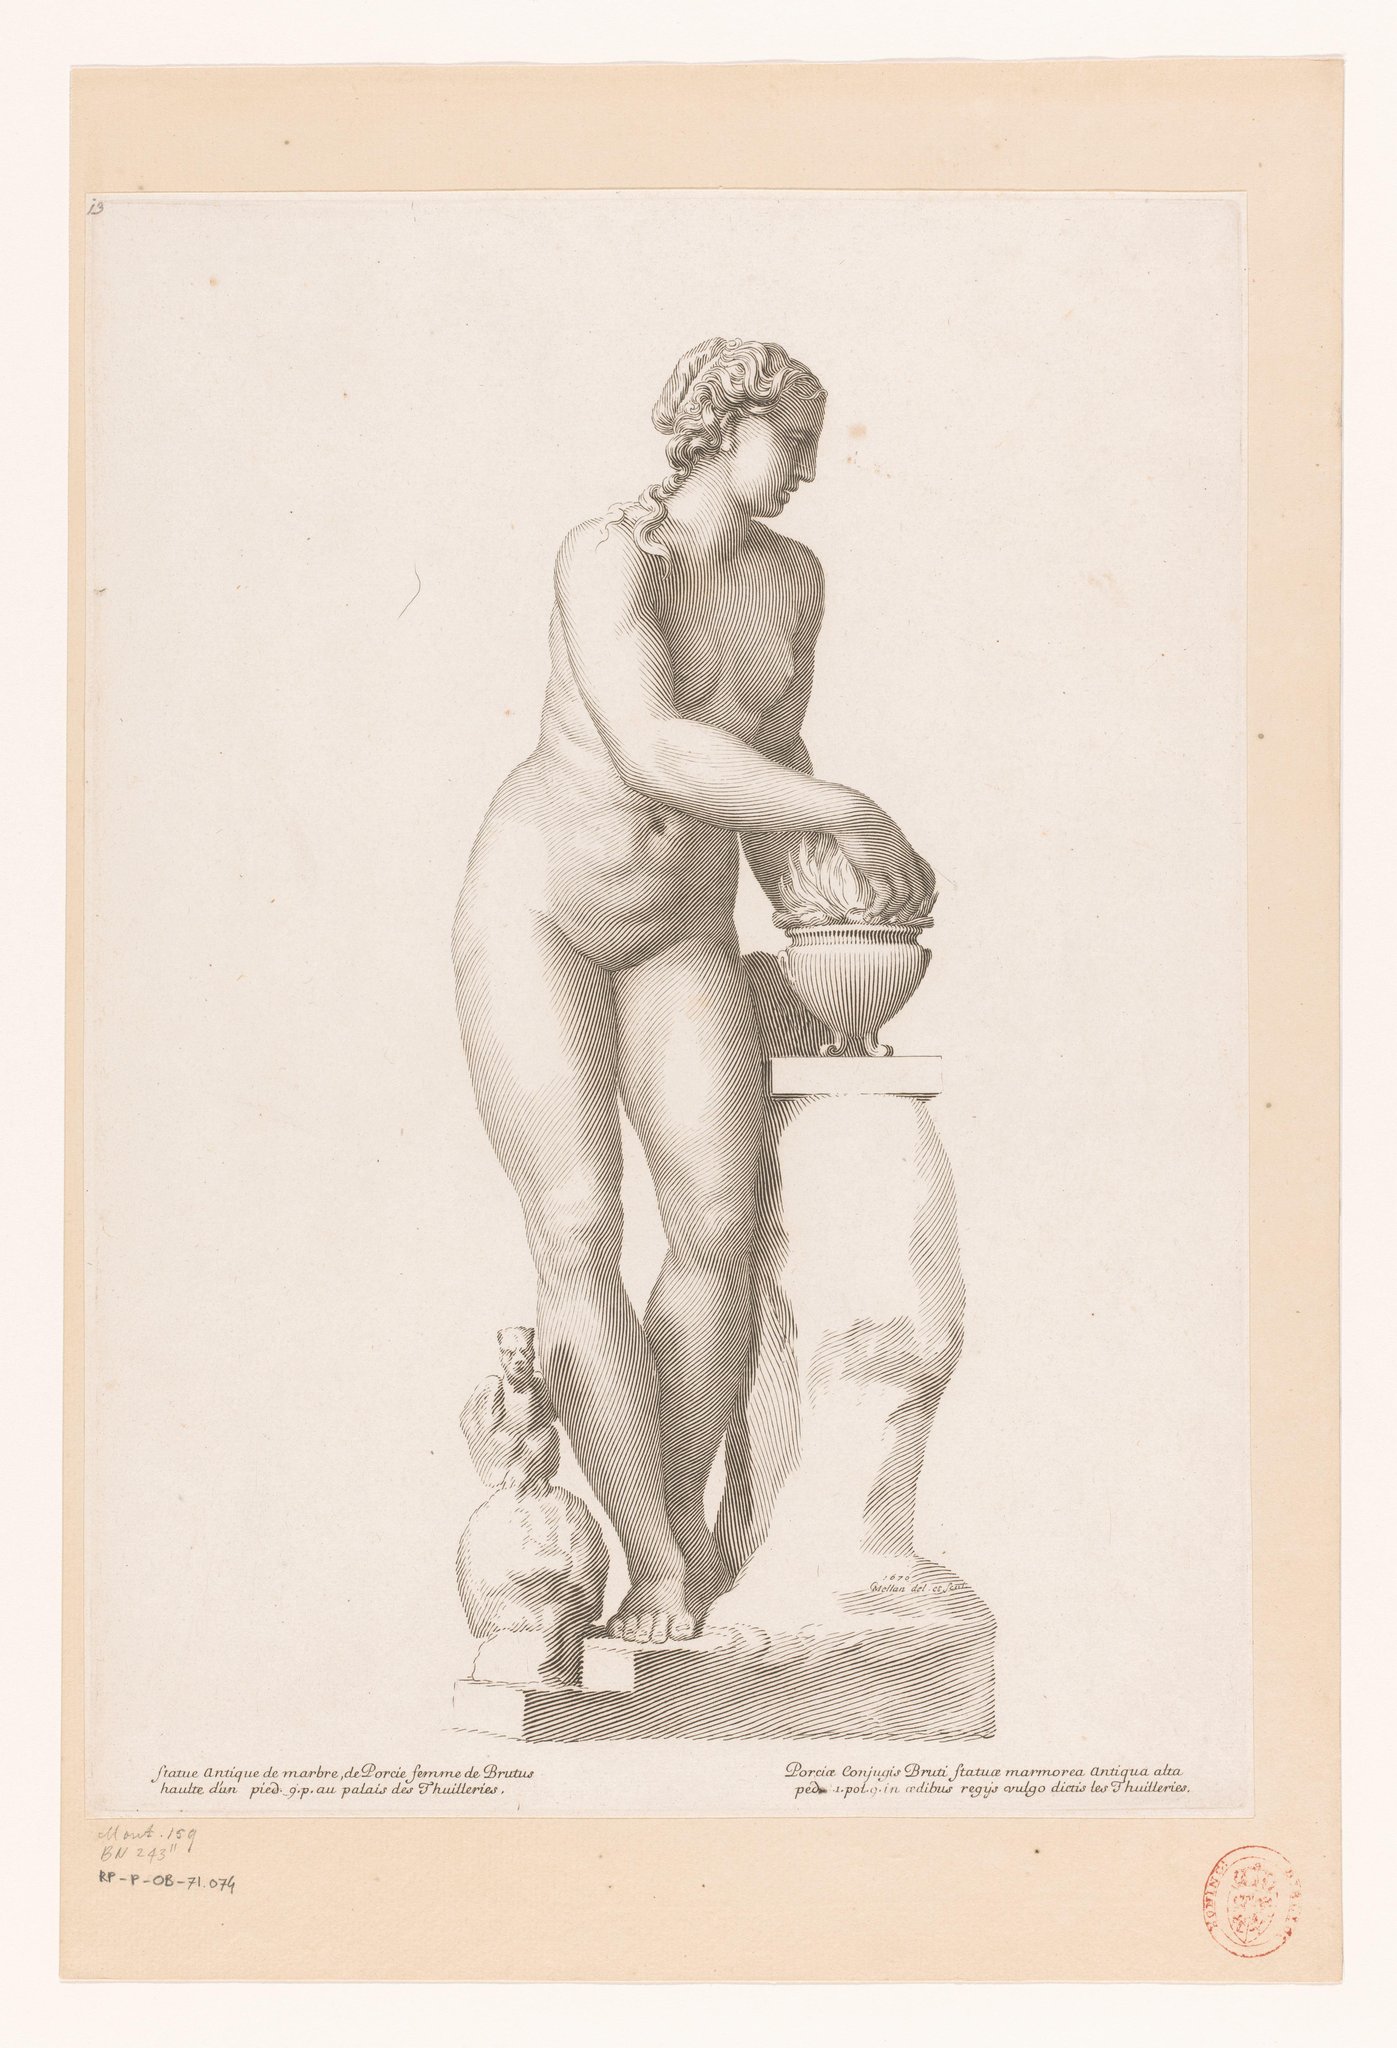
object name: print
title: Standbeeld van Porcia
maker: claude mellan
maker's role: draughtsman, print maker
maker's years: 1598-1688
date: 1670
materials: paper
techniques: engraving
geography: france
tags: (story of) porcia, piece of sculpture, reproduction of a piece of sculpture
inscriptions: collector's mark: Lugt 240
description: Prent gebruikt voor: Félibien, André. Tableaux du Cabinet du roy. Statues et bustes antiques des maisons royales. Parijs: Imprimerie Royale, 1677. Het boek bevat 61 prenten van beelden en bustes uit Franse koninklijke collectie. Mellan vervaardigde in totaal achttien platen (zie ook British Museum, inv.nr. 1874,0808.1488). Het beeld bevindt zich in Versailles.